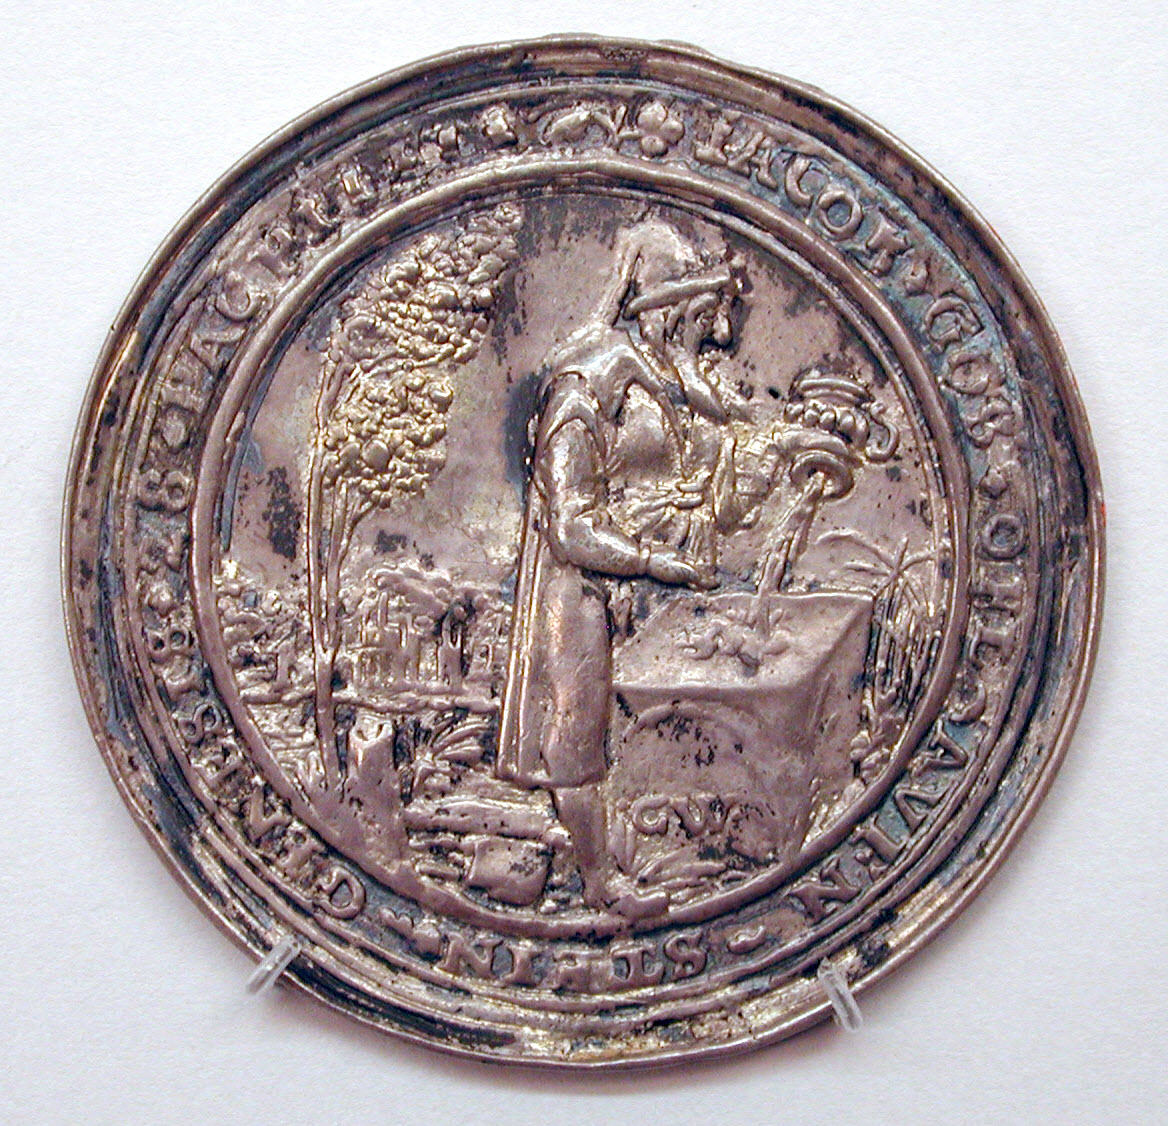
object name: medal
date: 1501-1600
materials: silver gilt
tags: men,medals